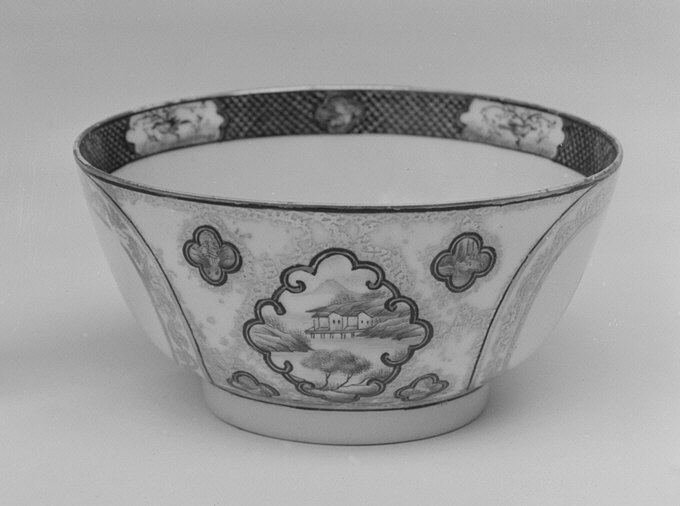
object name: cup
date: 1785-1800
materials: hard paste porcelain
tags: landscapes